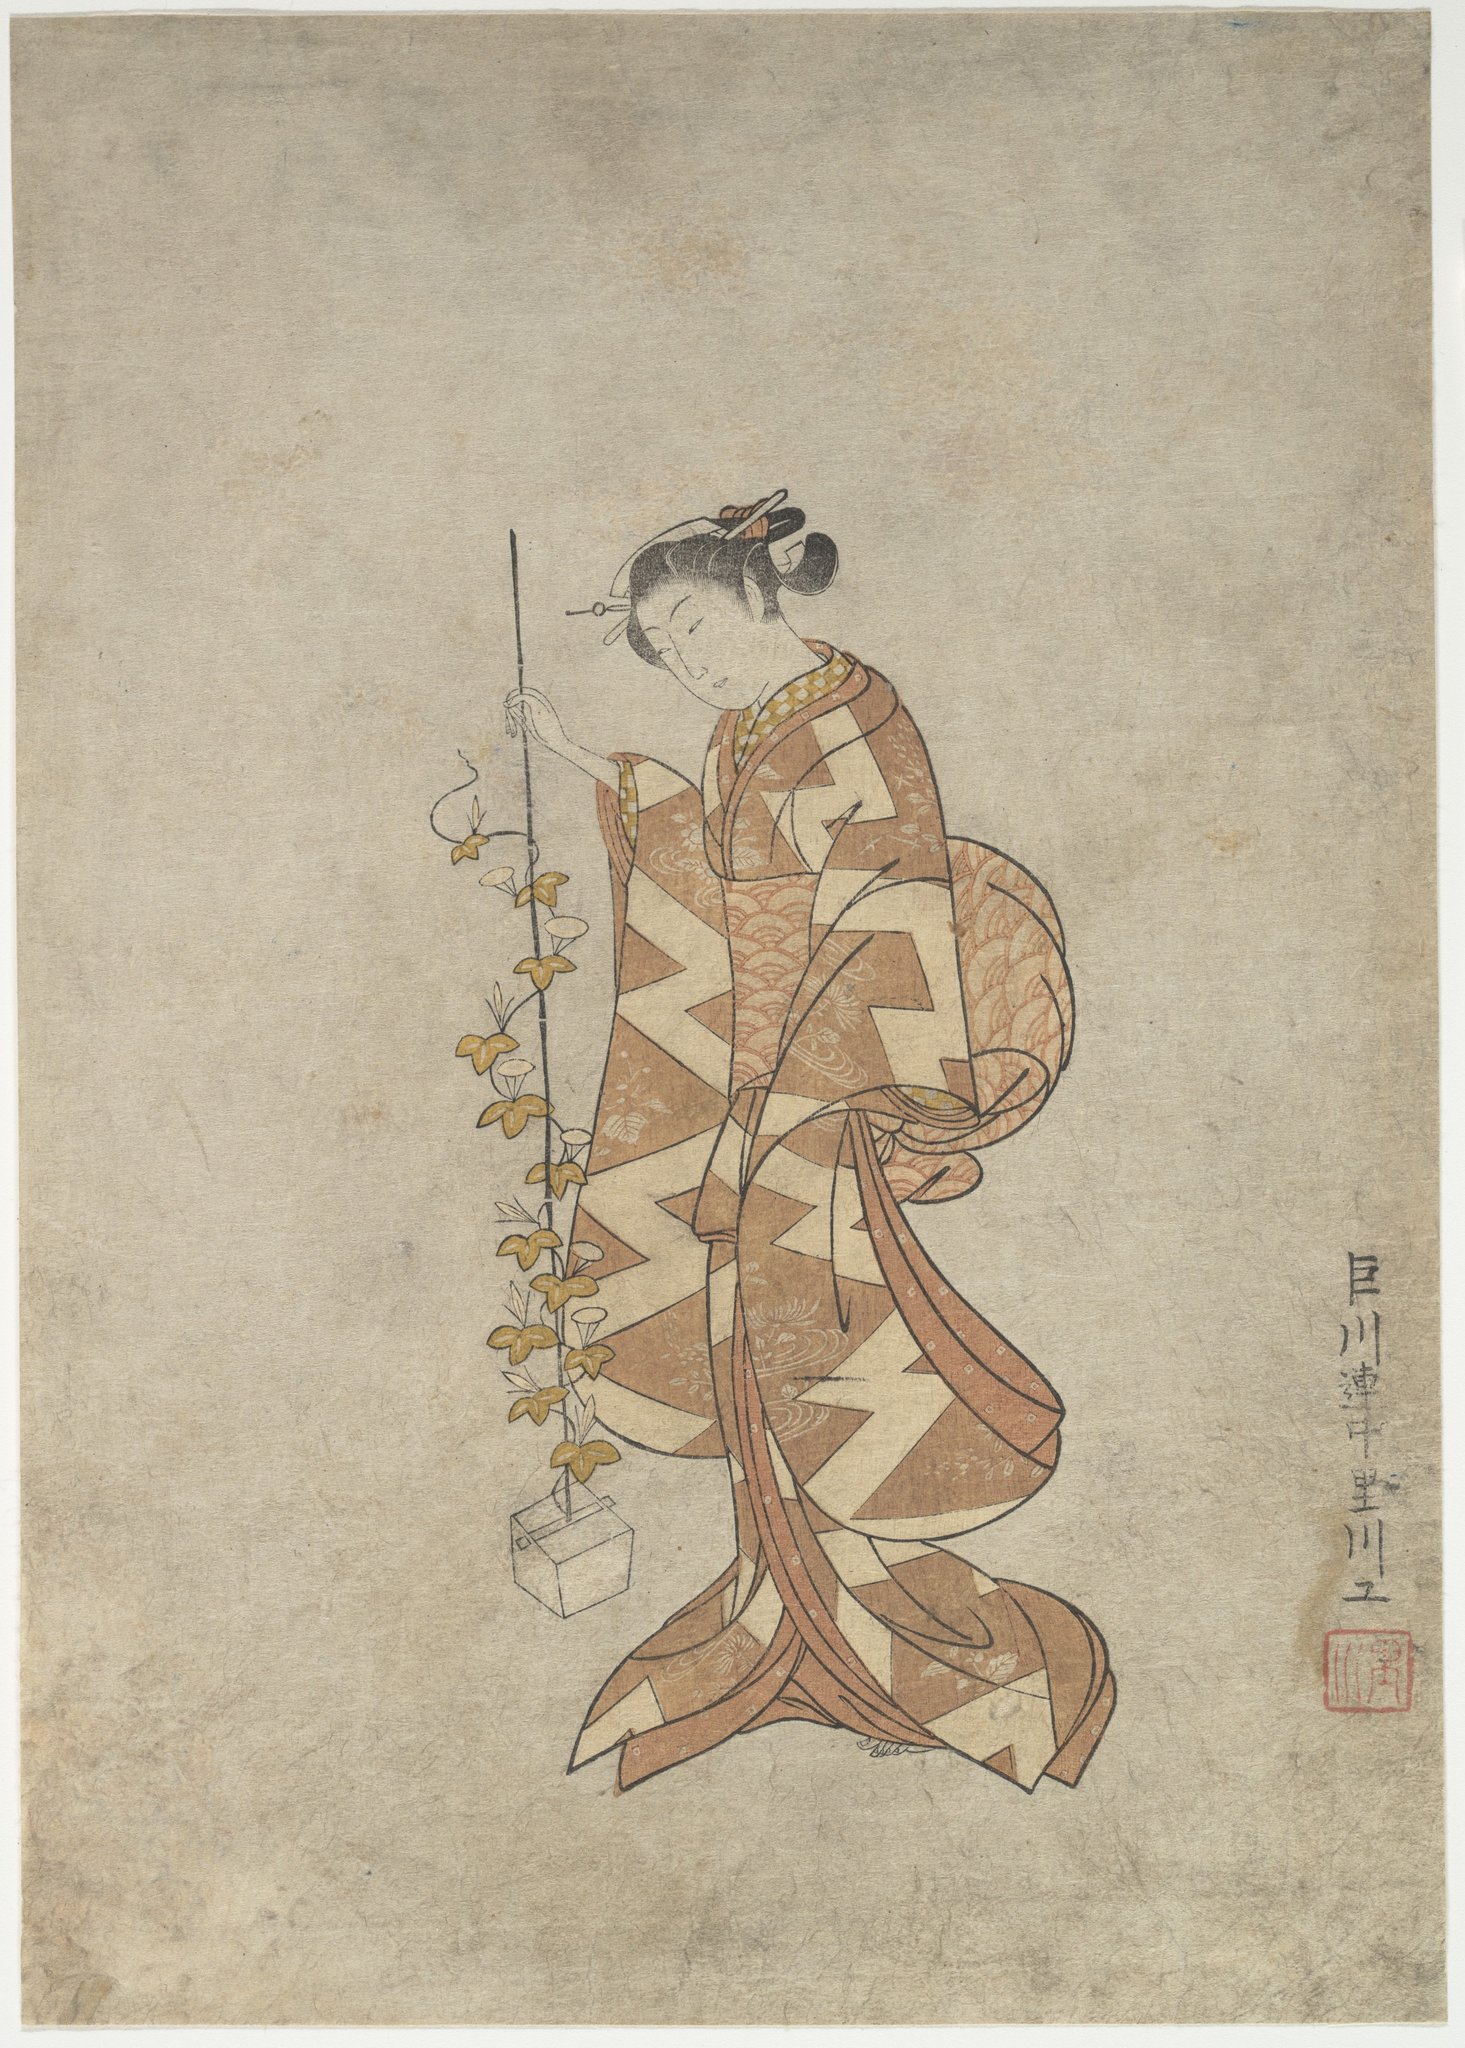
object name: print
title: Modern Representation of the Poetess Kaga no Chiyo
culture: japanese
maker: suzuki harunobu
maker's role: artist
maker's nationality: japanese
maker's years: 1725-1770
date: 1765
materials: ink, paper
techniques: woodblock print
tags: women,poets